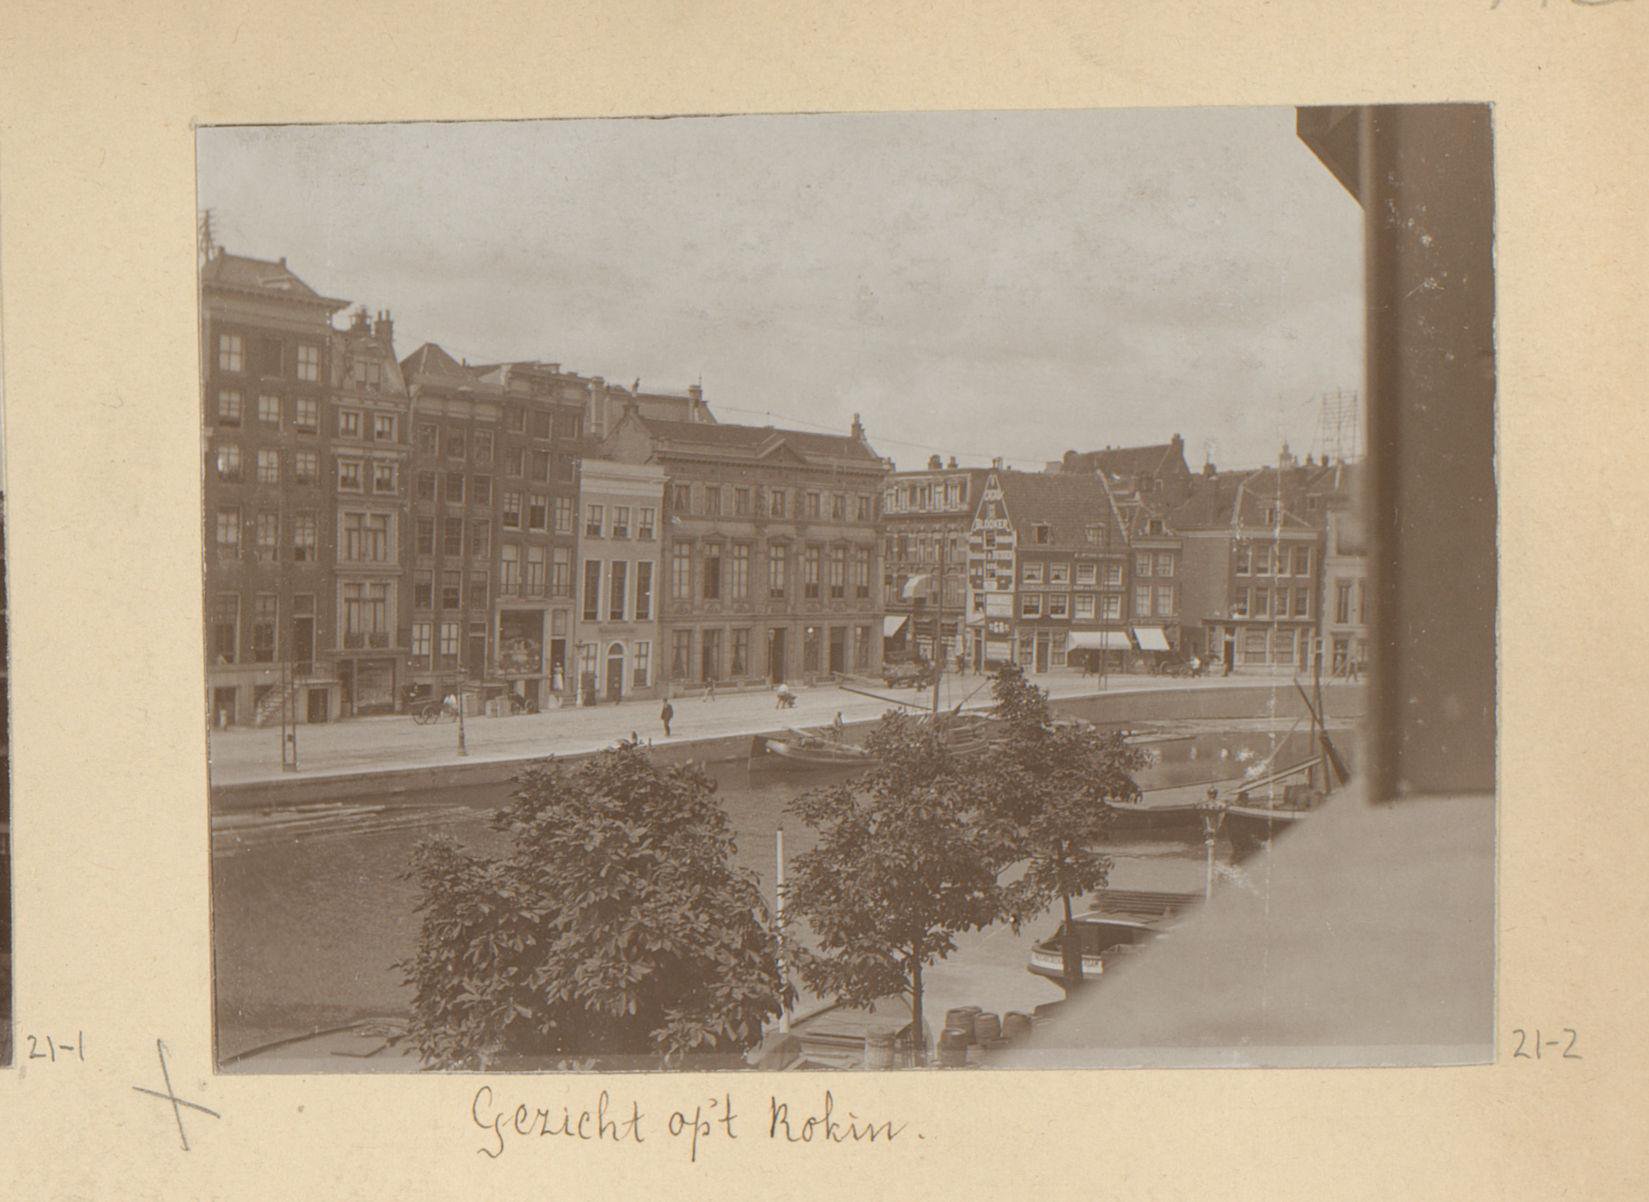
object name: album leaf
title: Gezicht op het Rokin, gezien vanuit De Nederlandse Bank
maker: hendrik herman van den berg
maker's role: amateurfotograaf, jurist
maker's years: 1875-1944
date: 1890-1894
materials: paper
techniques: collodion silver print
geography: amsterdam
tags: urban housing, canals, waters (in city)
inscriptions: inscription: ‘Amsterdam +/- 1890’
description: Foto 2 op albumblad 21 uit album "Amsterdam 1890-1894".